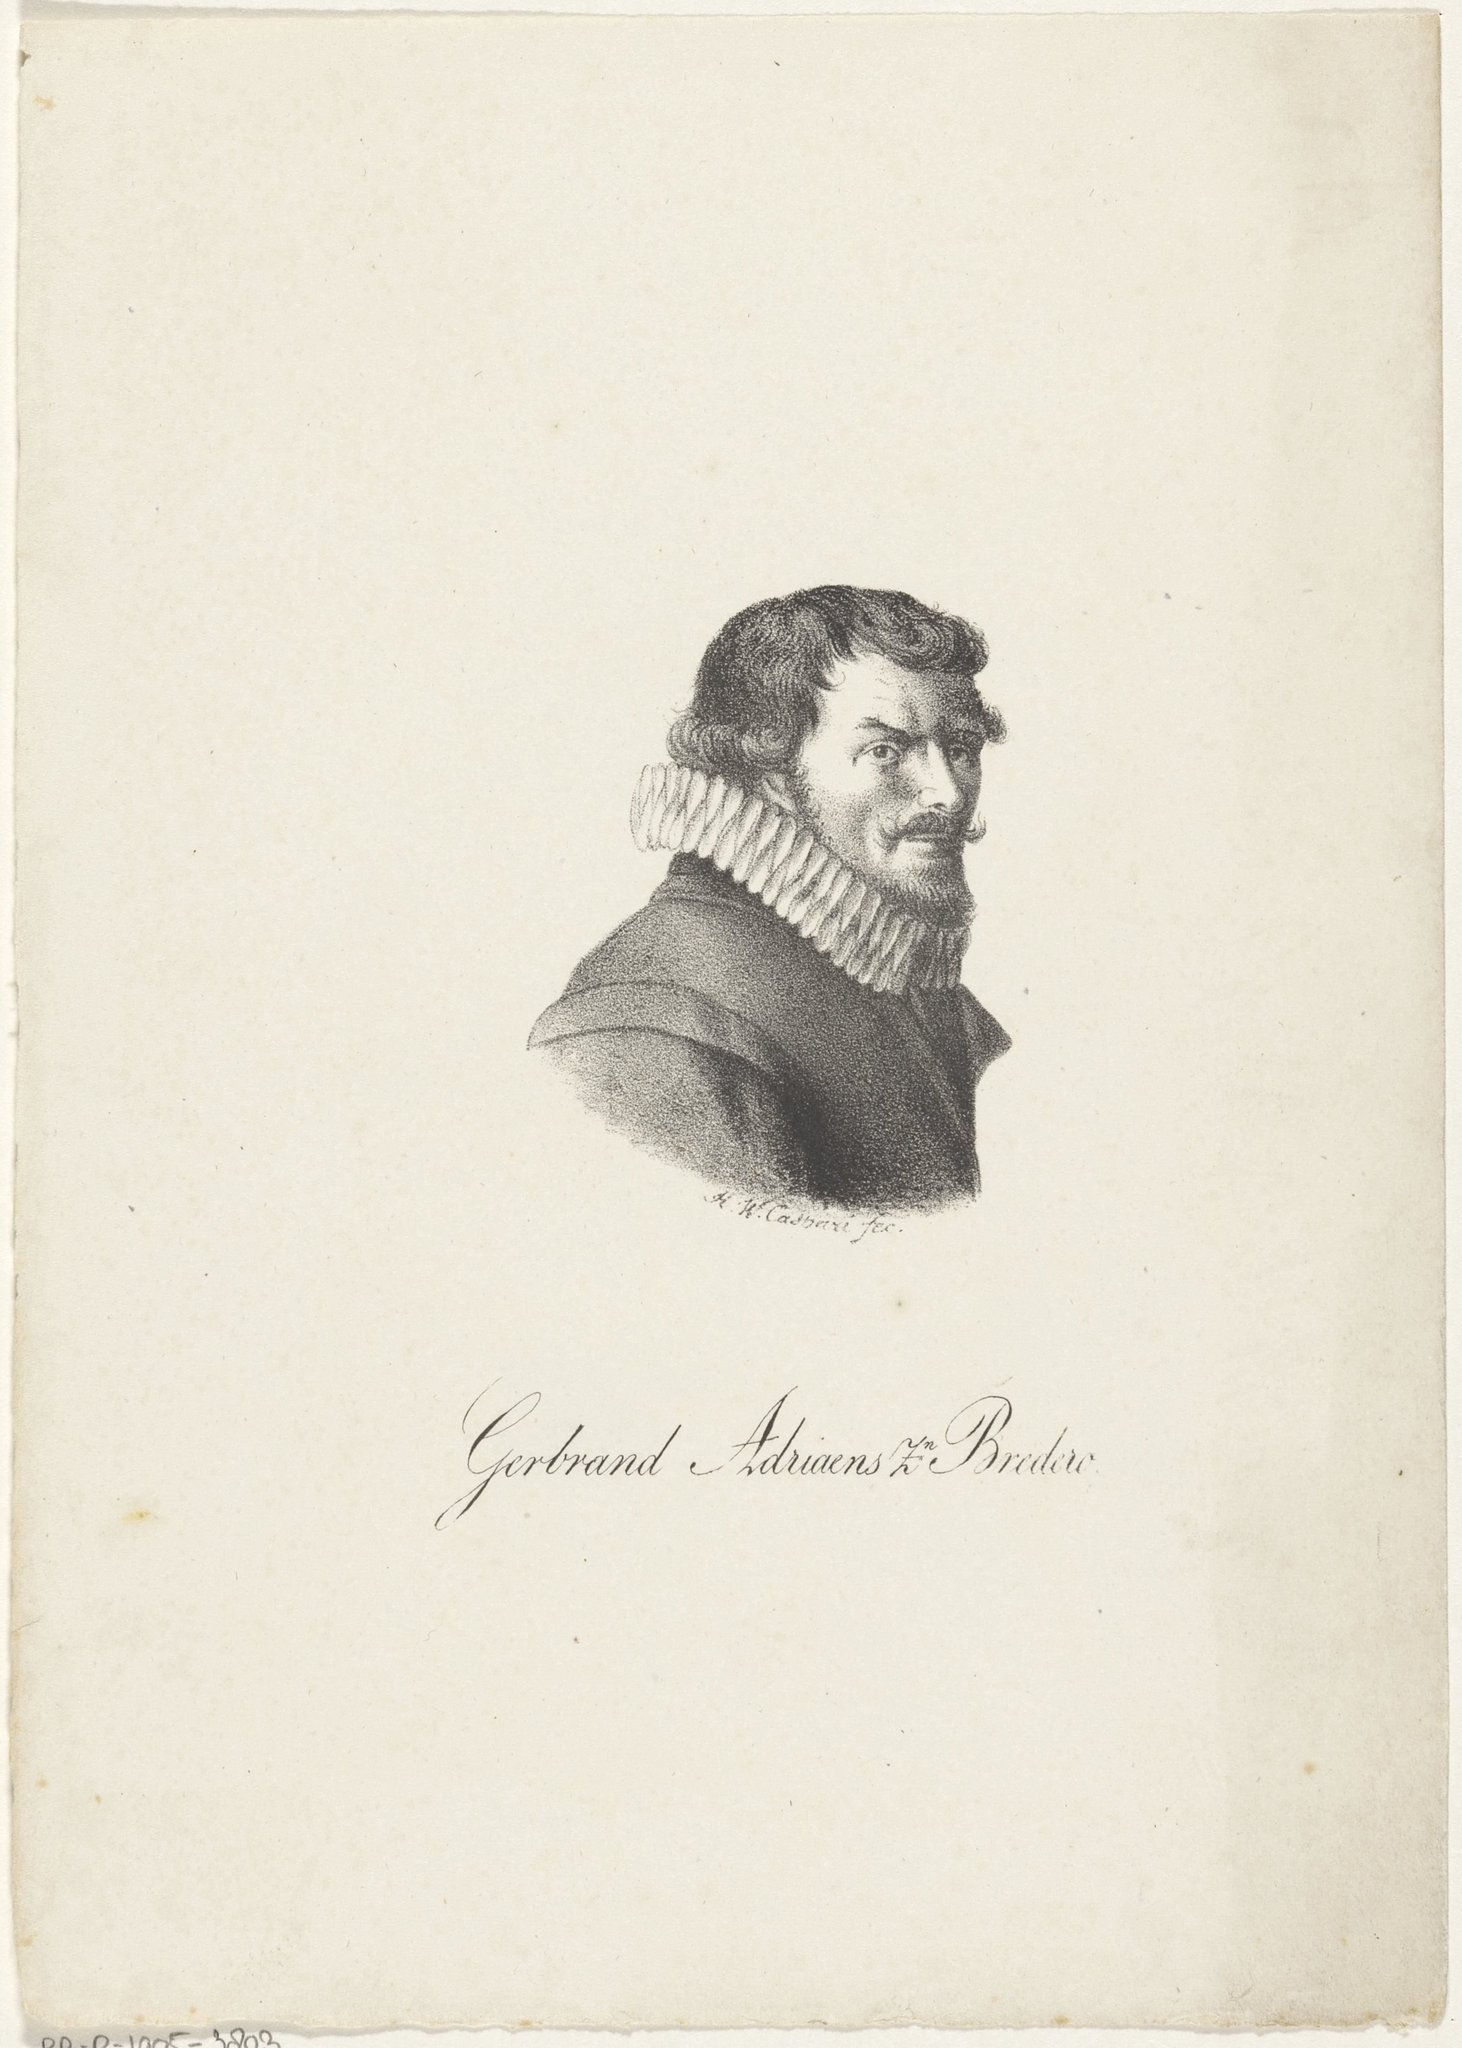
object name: print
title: Portret van Gerbrand Adriaenszn. Brederode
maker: hendrik willem caspari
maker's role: draughtsman, print maker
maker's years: 1770-1829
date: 1809-1829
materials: paper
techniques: lithograph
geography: amsterdam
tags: amsterdam, gerbrand adriaensz. bredero, historical persons (+ head (and shoulders) (portrait)), neck-gear ~ clothing (with name), neck-gear: collar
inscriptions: collector's mark: Lugt 2228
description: De geportretteerde draagt een plooikraag en kijkt naar rechts. Onder het portret zijn naam.